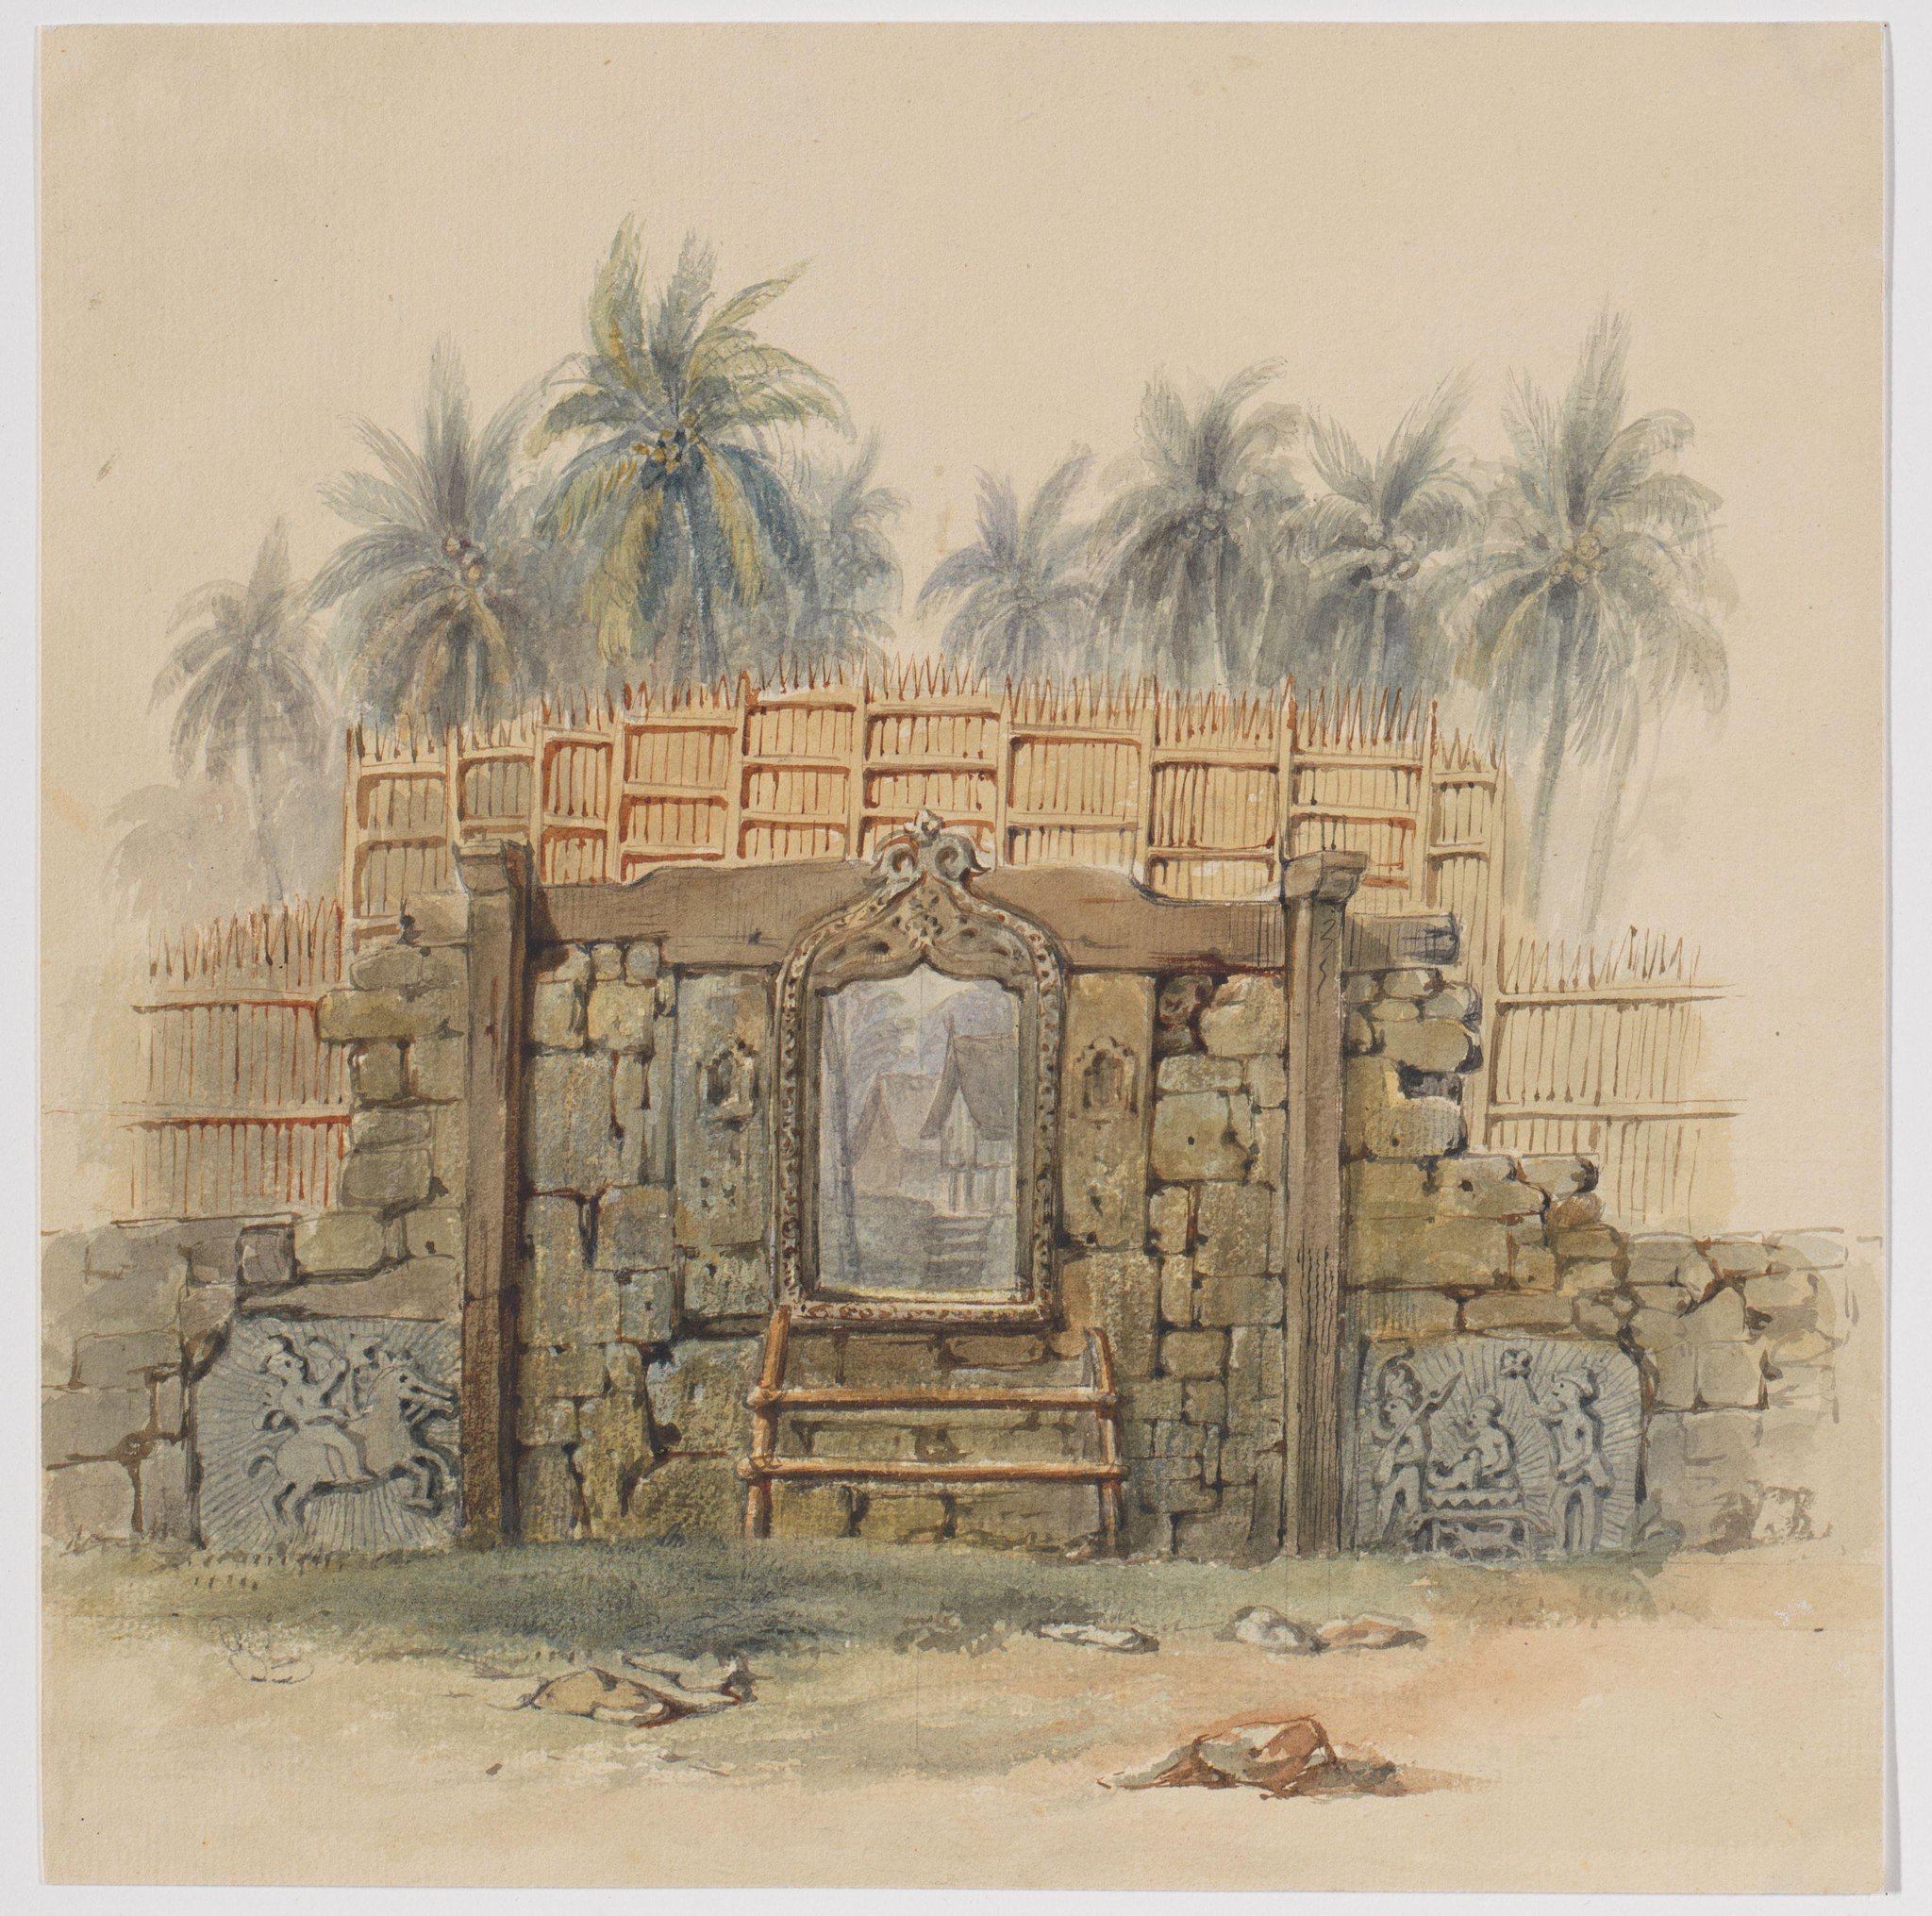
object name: topographical view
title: Koraalstenen muur met omlijste opening naar het dorp Dula (Dullah), eiland Dullah, Kai eilanden, Zuidoost-Molukken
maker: adrianus johannes bik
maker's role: draughtsman, print maker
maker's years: 1790-1872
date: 1824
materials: ink, paper, pencil, watercolor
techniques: brush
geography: south moluccas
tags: molukken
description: Koraalstenen muur met omlijste deur en reliëfs aan weerskanten, met doorkijkje naar het dorp Dula (Dullah). De tekenaar bevindt zich op het terrein van het graf van de raja van Dullah, dat buiten het ommuurde dorp (negorij) ligt.